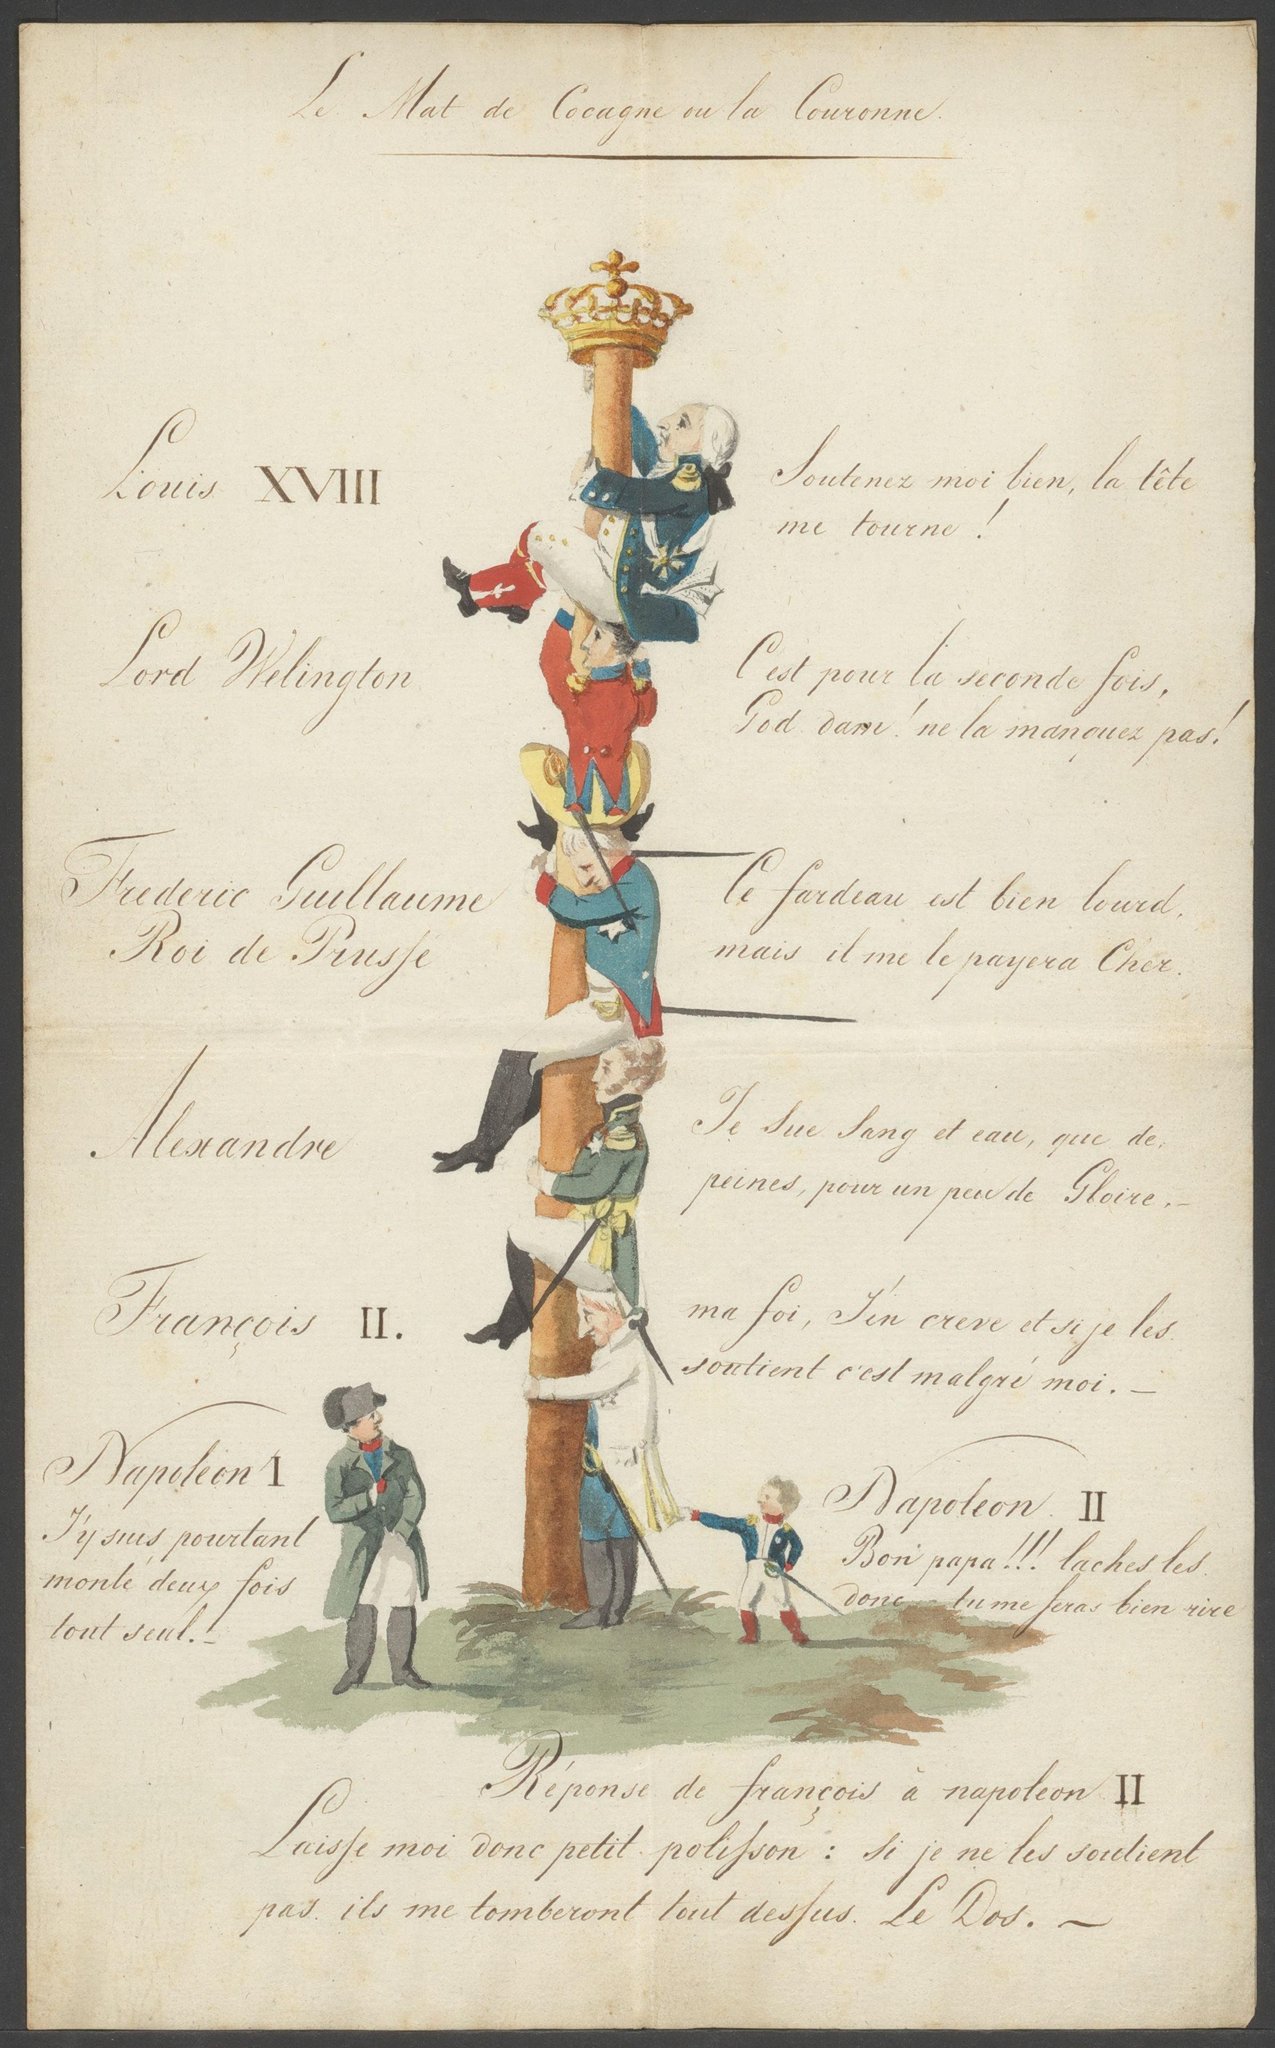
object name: drawing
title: Meiboom van de kroon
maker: Anonymous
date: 1811-1821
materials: ink, paper, watercolor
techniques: brush, pen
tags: paris, lodewijk xviii (koning van frankrijk), vienna, walmer castle, arthur wellesley of wellington, frans ii (rooms-duits keizer), napoleon i (emperor of the french), maypole, ruler, sovereign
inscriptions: collector's mark: Lugt 1641, stamp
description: Een meiboom waar verschillende figuren naar boven klimmen. Bovenaan Lodewijk XVIII, koning van Frankrijk naast de meiboom kijkt Napoleon I, keizer der Fransen. Onderwerpsrubrieken binnen de Atlas Zeden en Gewoonten: Zeden en Gewoonten in engeren zin. Volksleven. Zinnebeeldige voorstellingen uit het volkleven op serieprenten. Maanden en diversen (allegorieën).